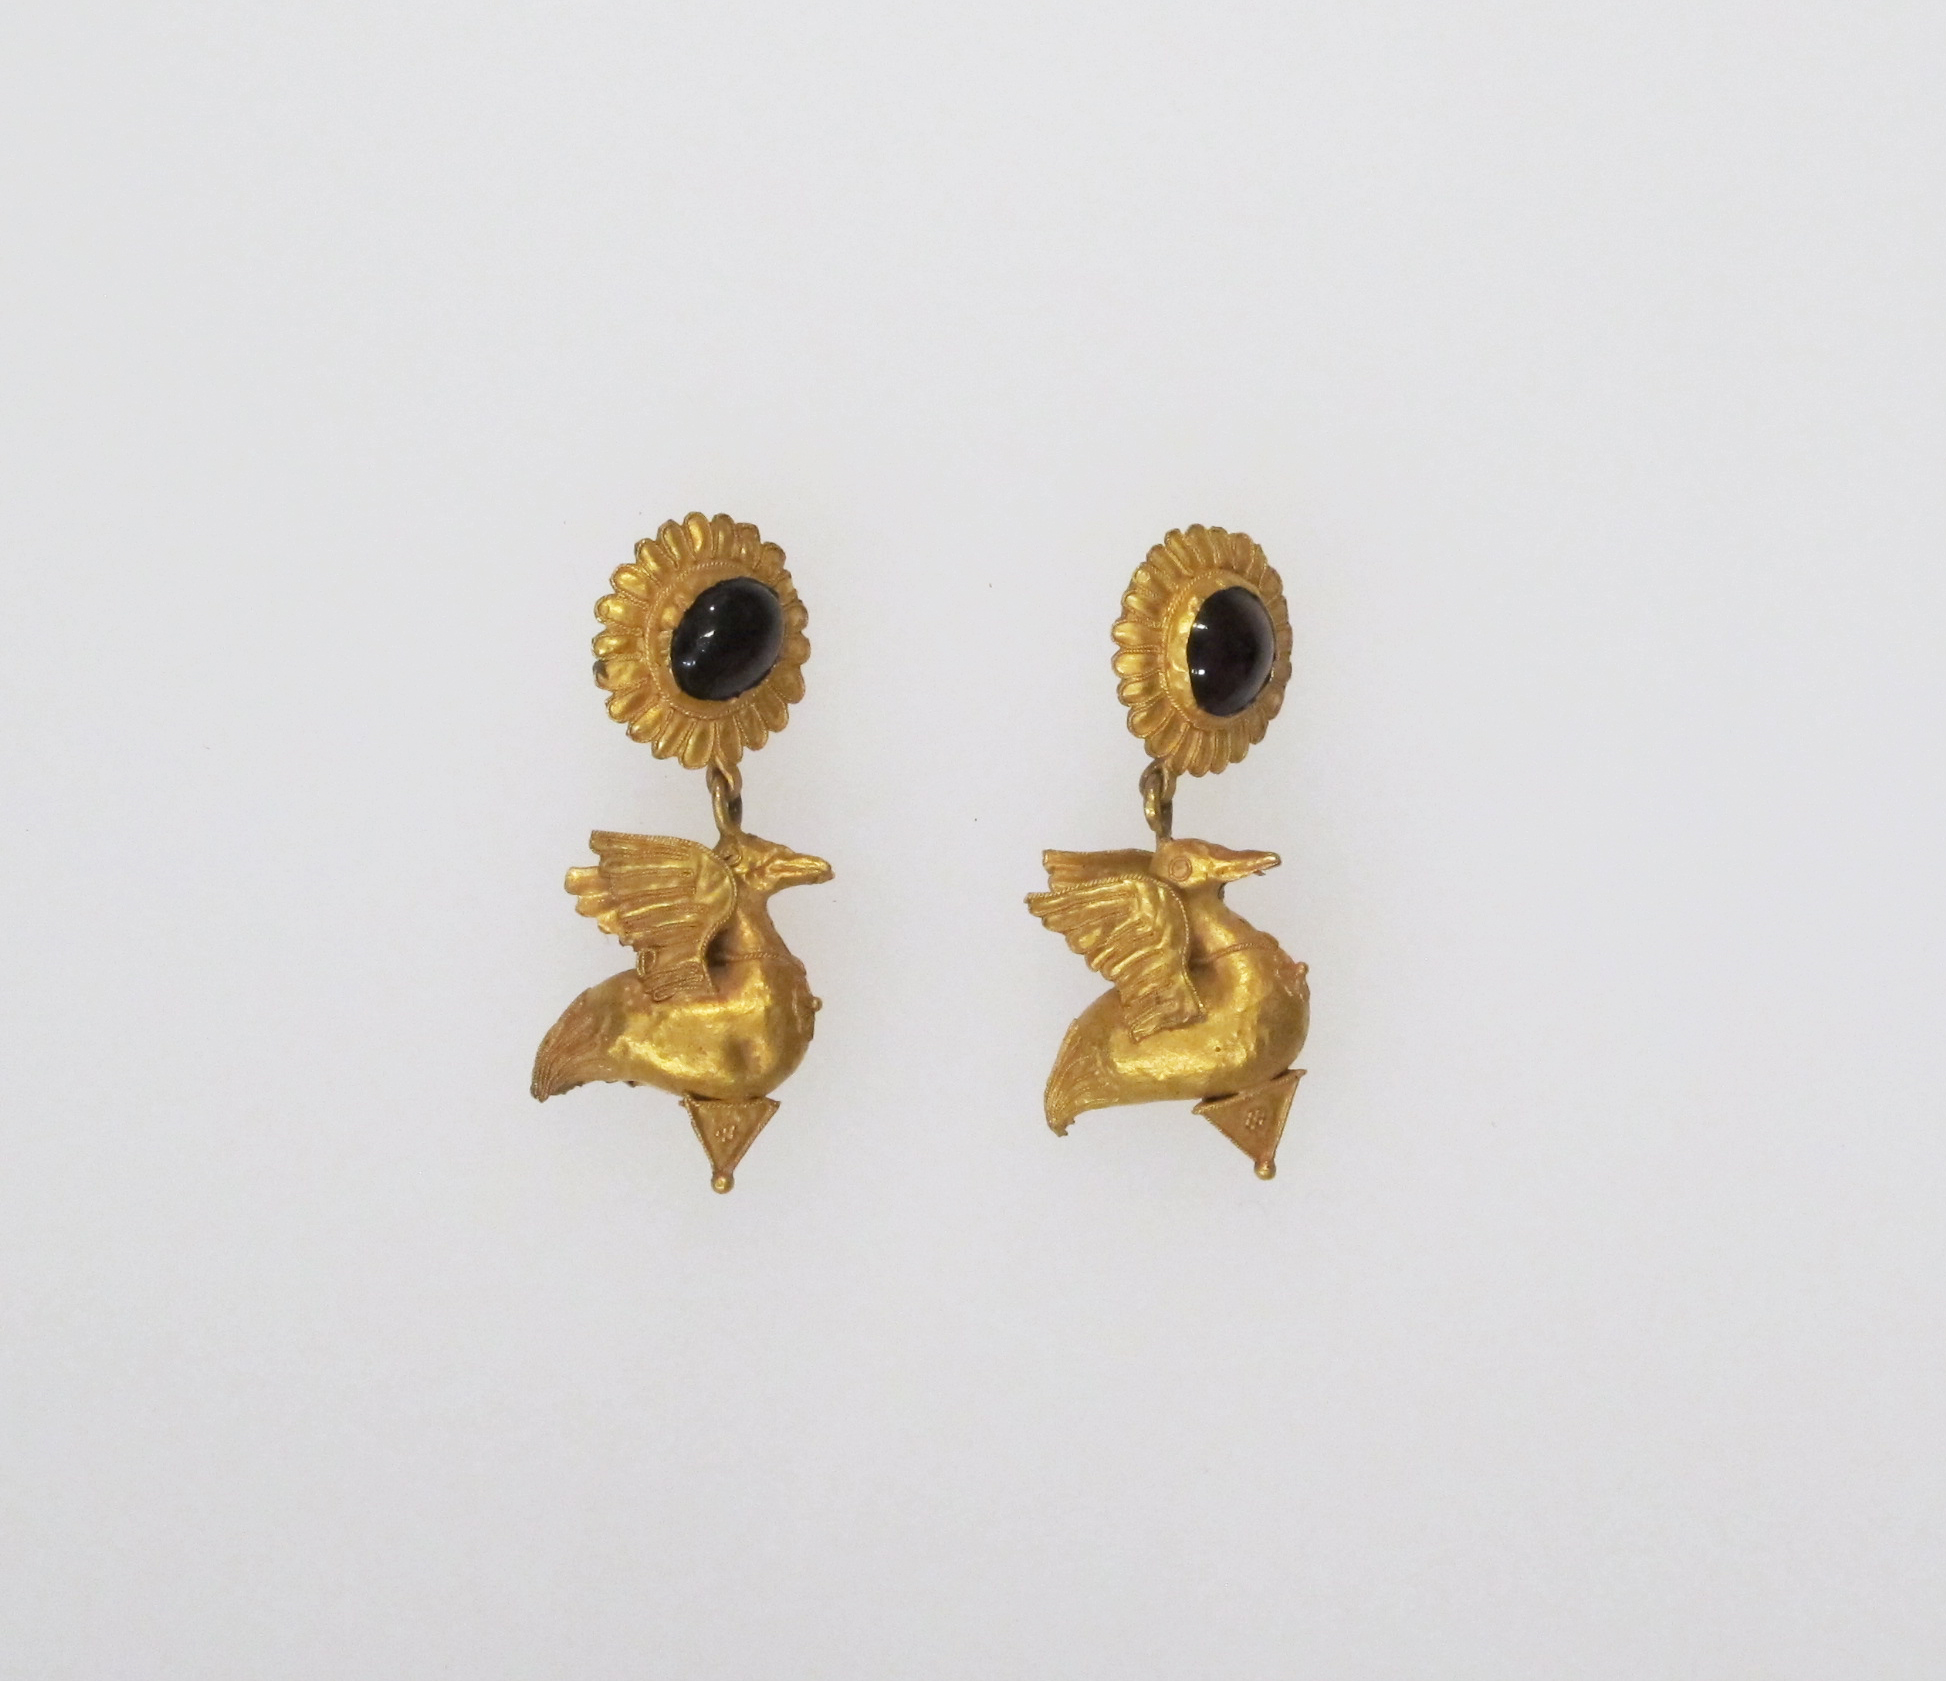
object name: earring with pendant of bird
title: Earring with pendants of birds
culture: greek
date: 400-301 BCE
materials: gold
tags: birds